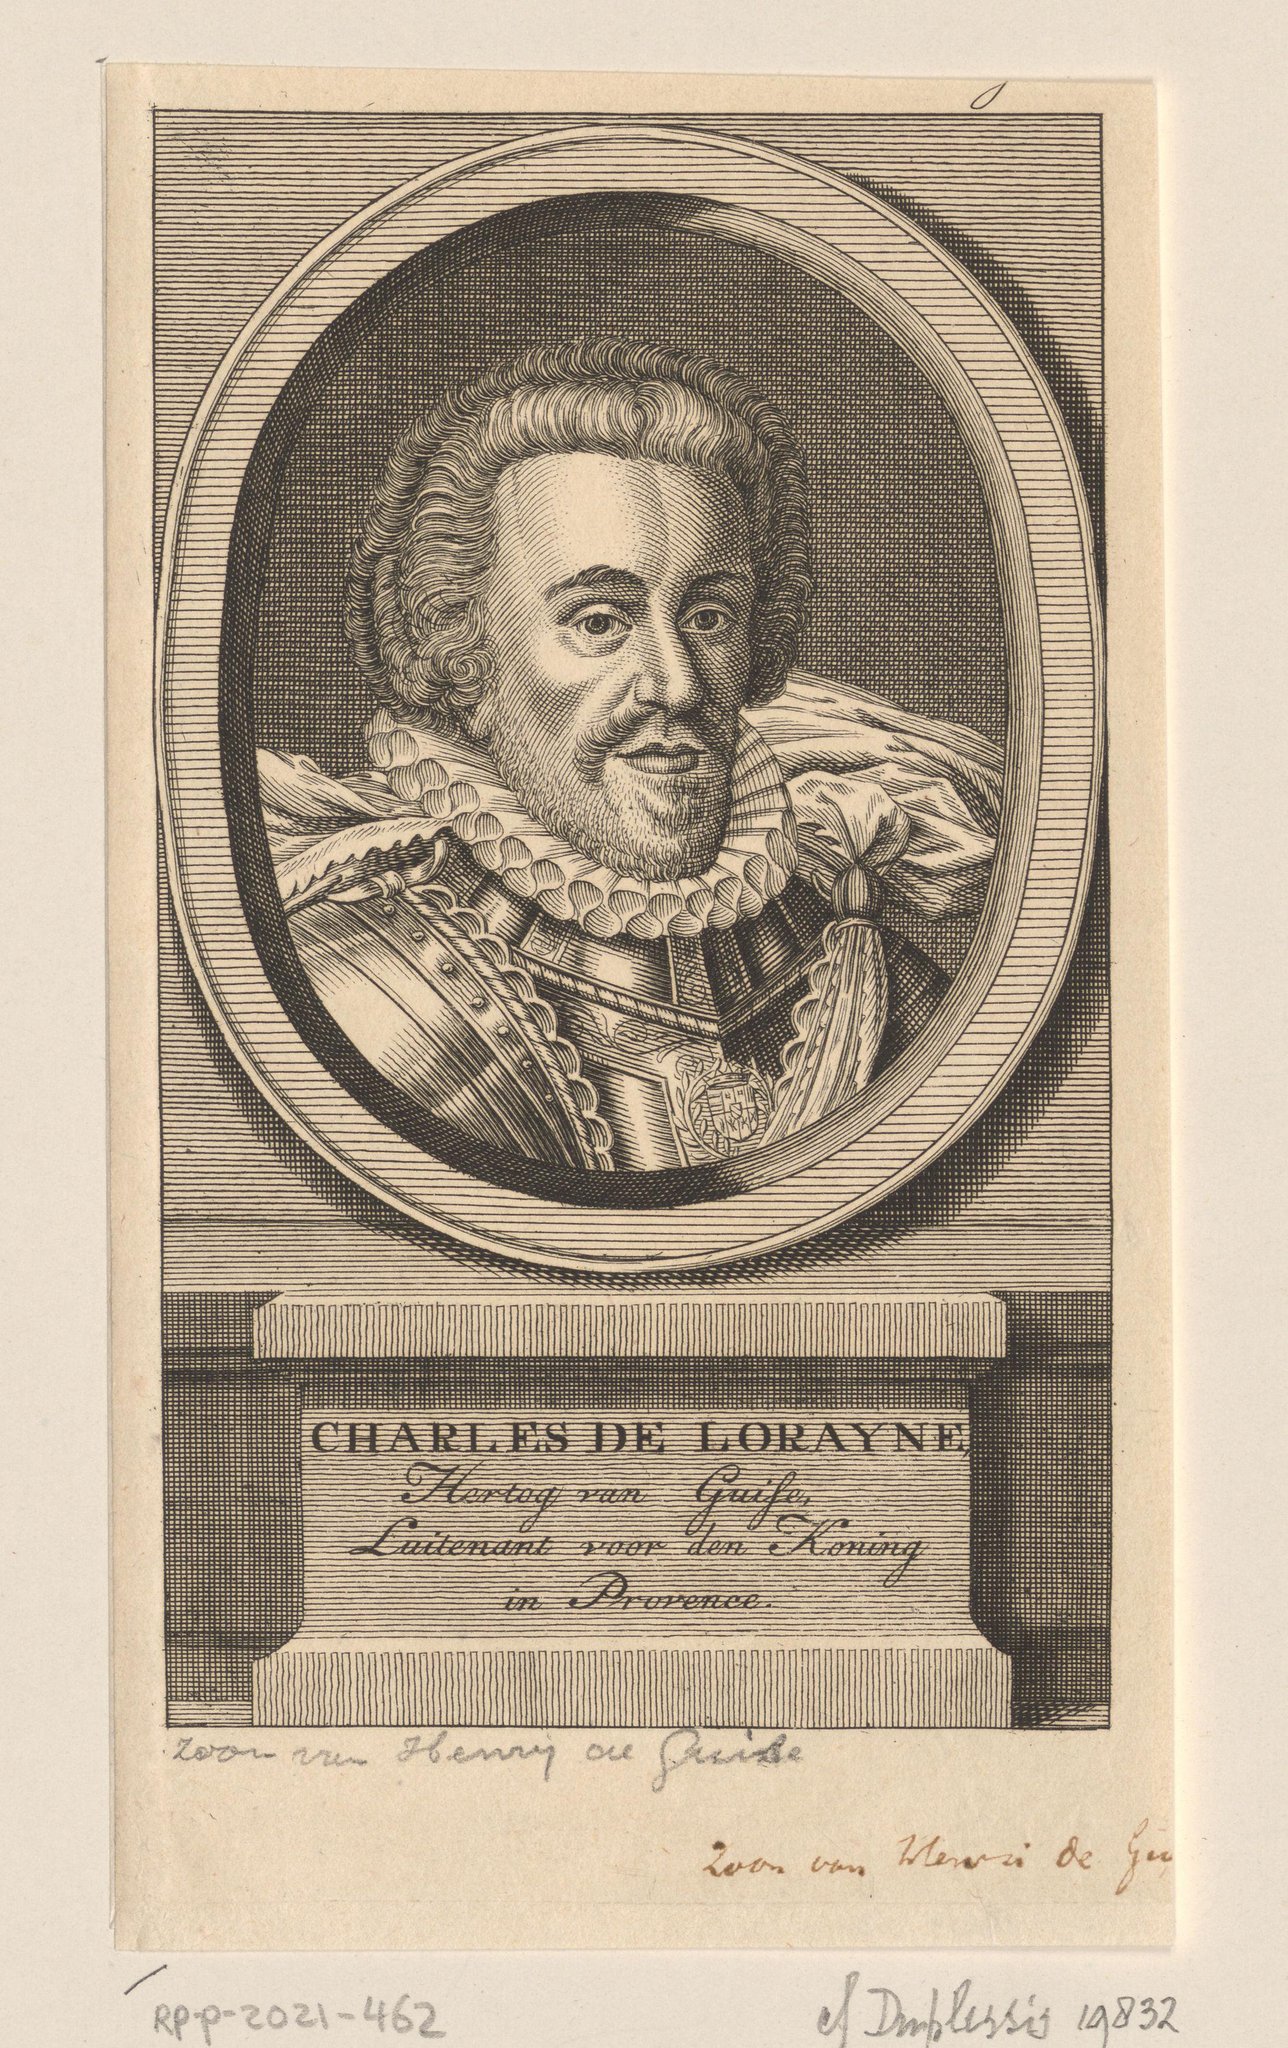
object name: print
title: Portret van Karel I, hertog de Guise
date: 1753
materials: paper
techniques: etching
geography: gorinchem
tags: historical persons, officer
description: Prent uit: Meteren, Emmanuel van. Historie van de oorlogen en geschiedenissen der Nederlanderen, en der zelver naburen. Gorinchem: Nicolaas Goetzee en zonen, 1753, dl. 6, p. 268.